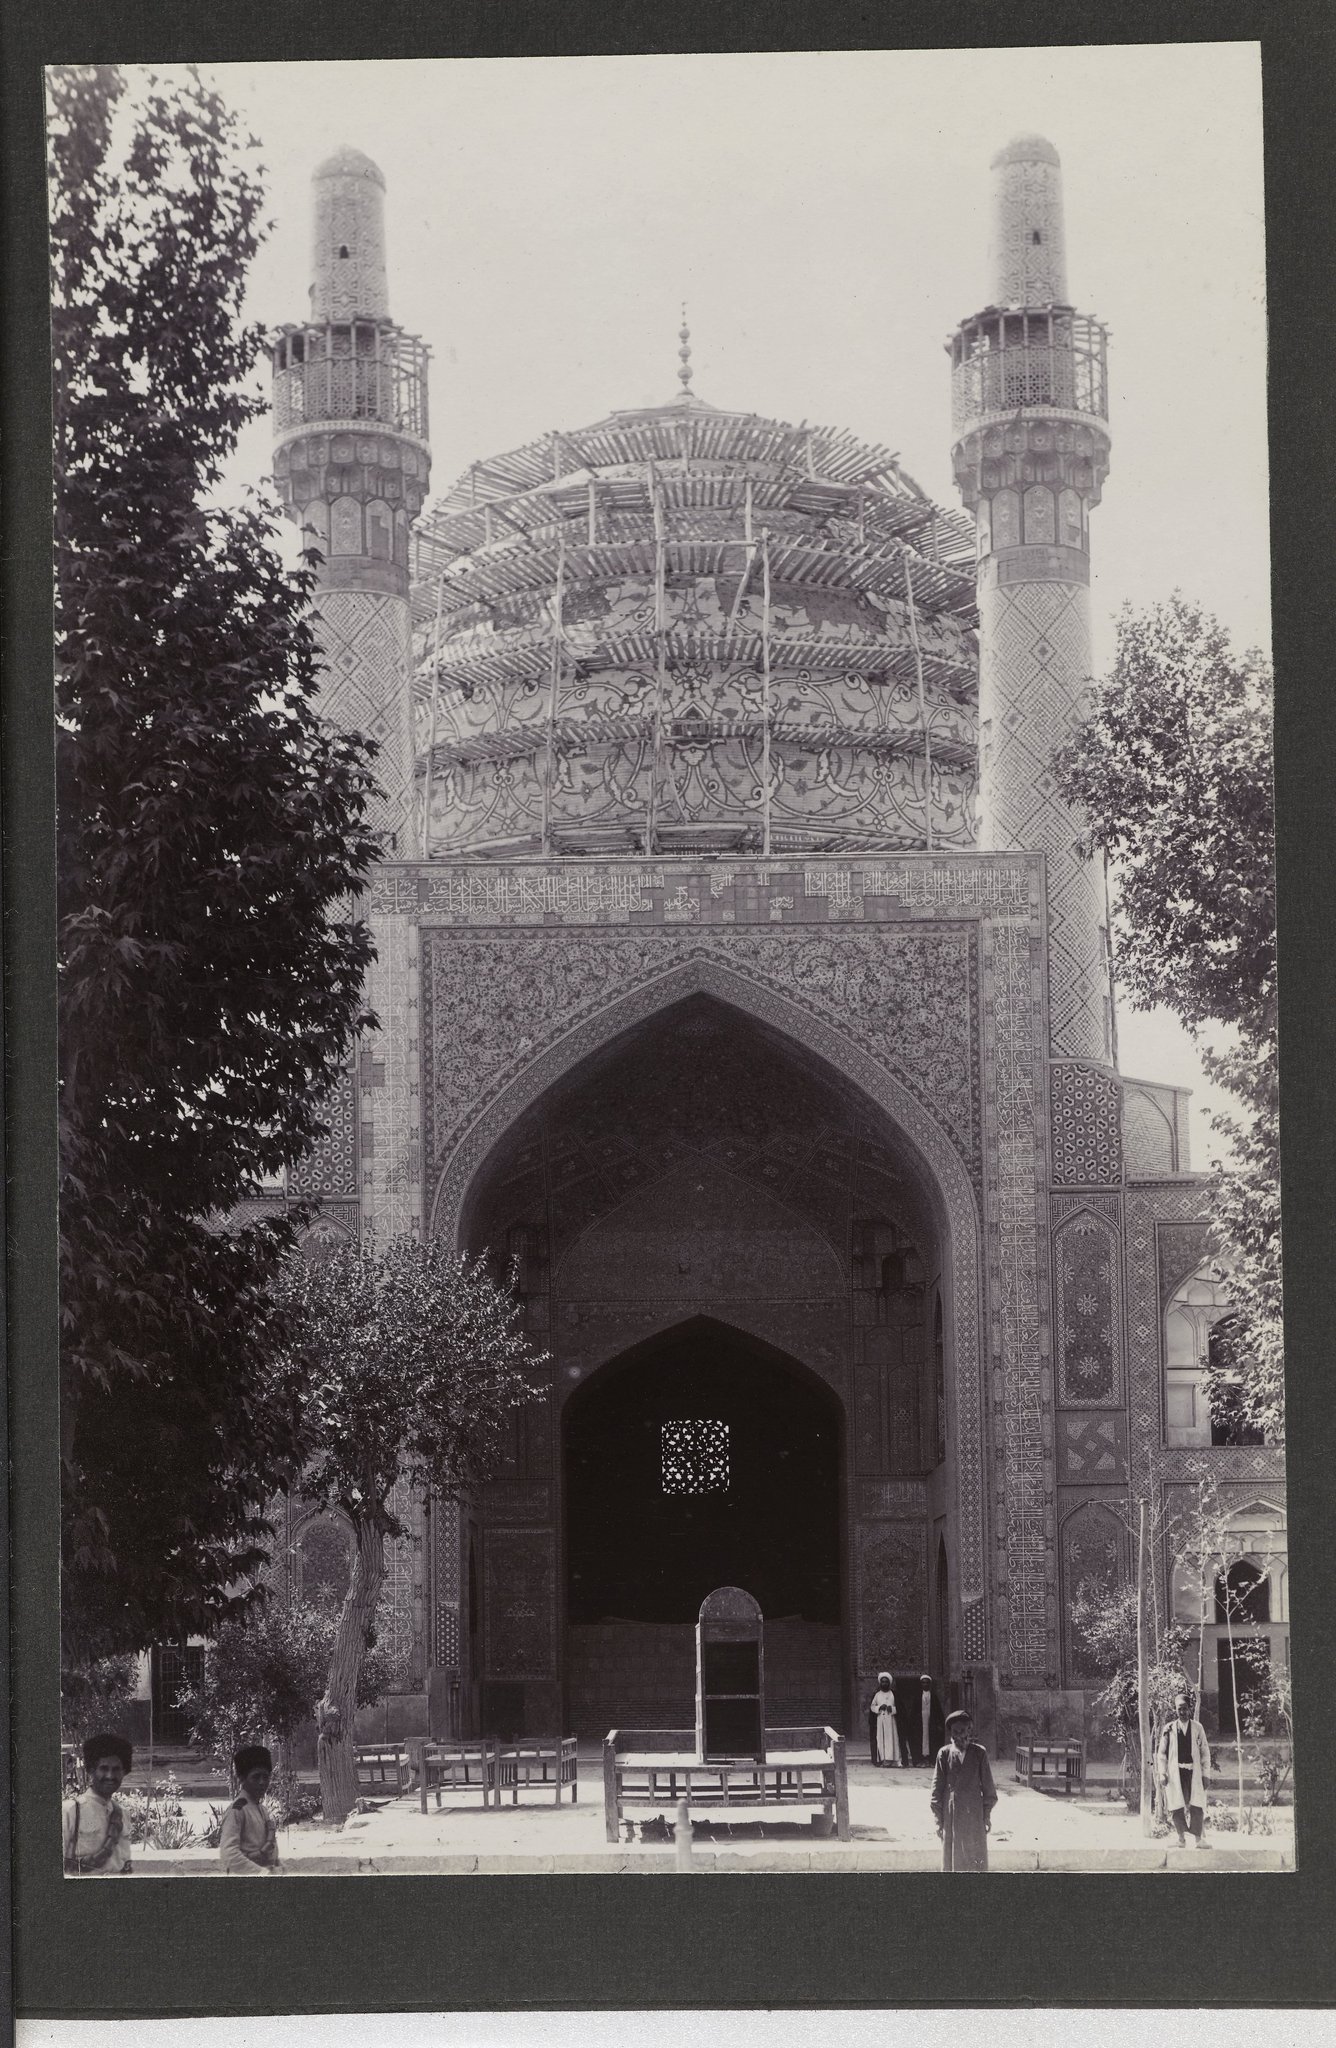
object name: photograph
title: Ingang van moskee (?) in Perzië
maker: a.g.a. van eelde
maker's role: engineer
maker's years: 1862-1950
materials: cardboard, paper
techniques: gelatin silver print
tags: iran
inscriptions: number: ‘51.’